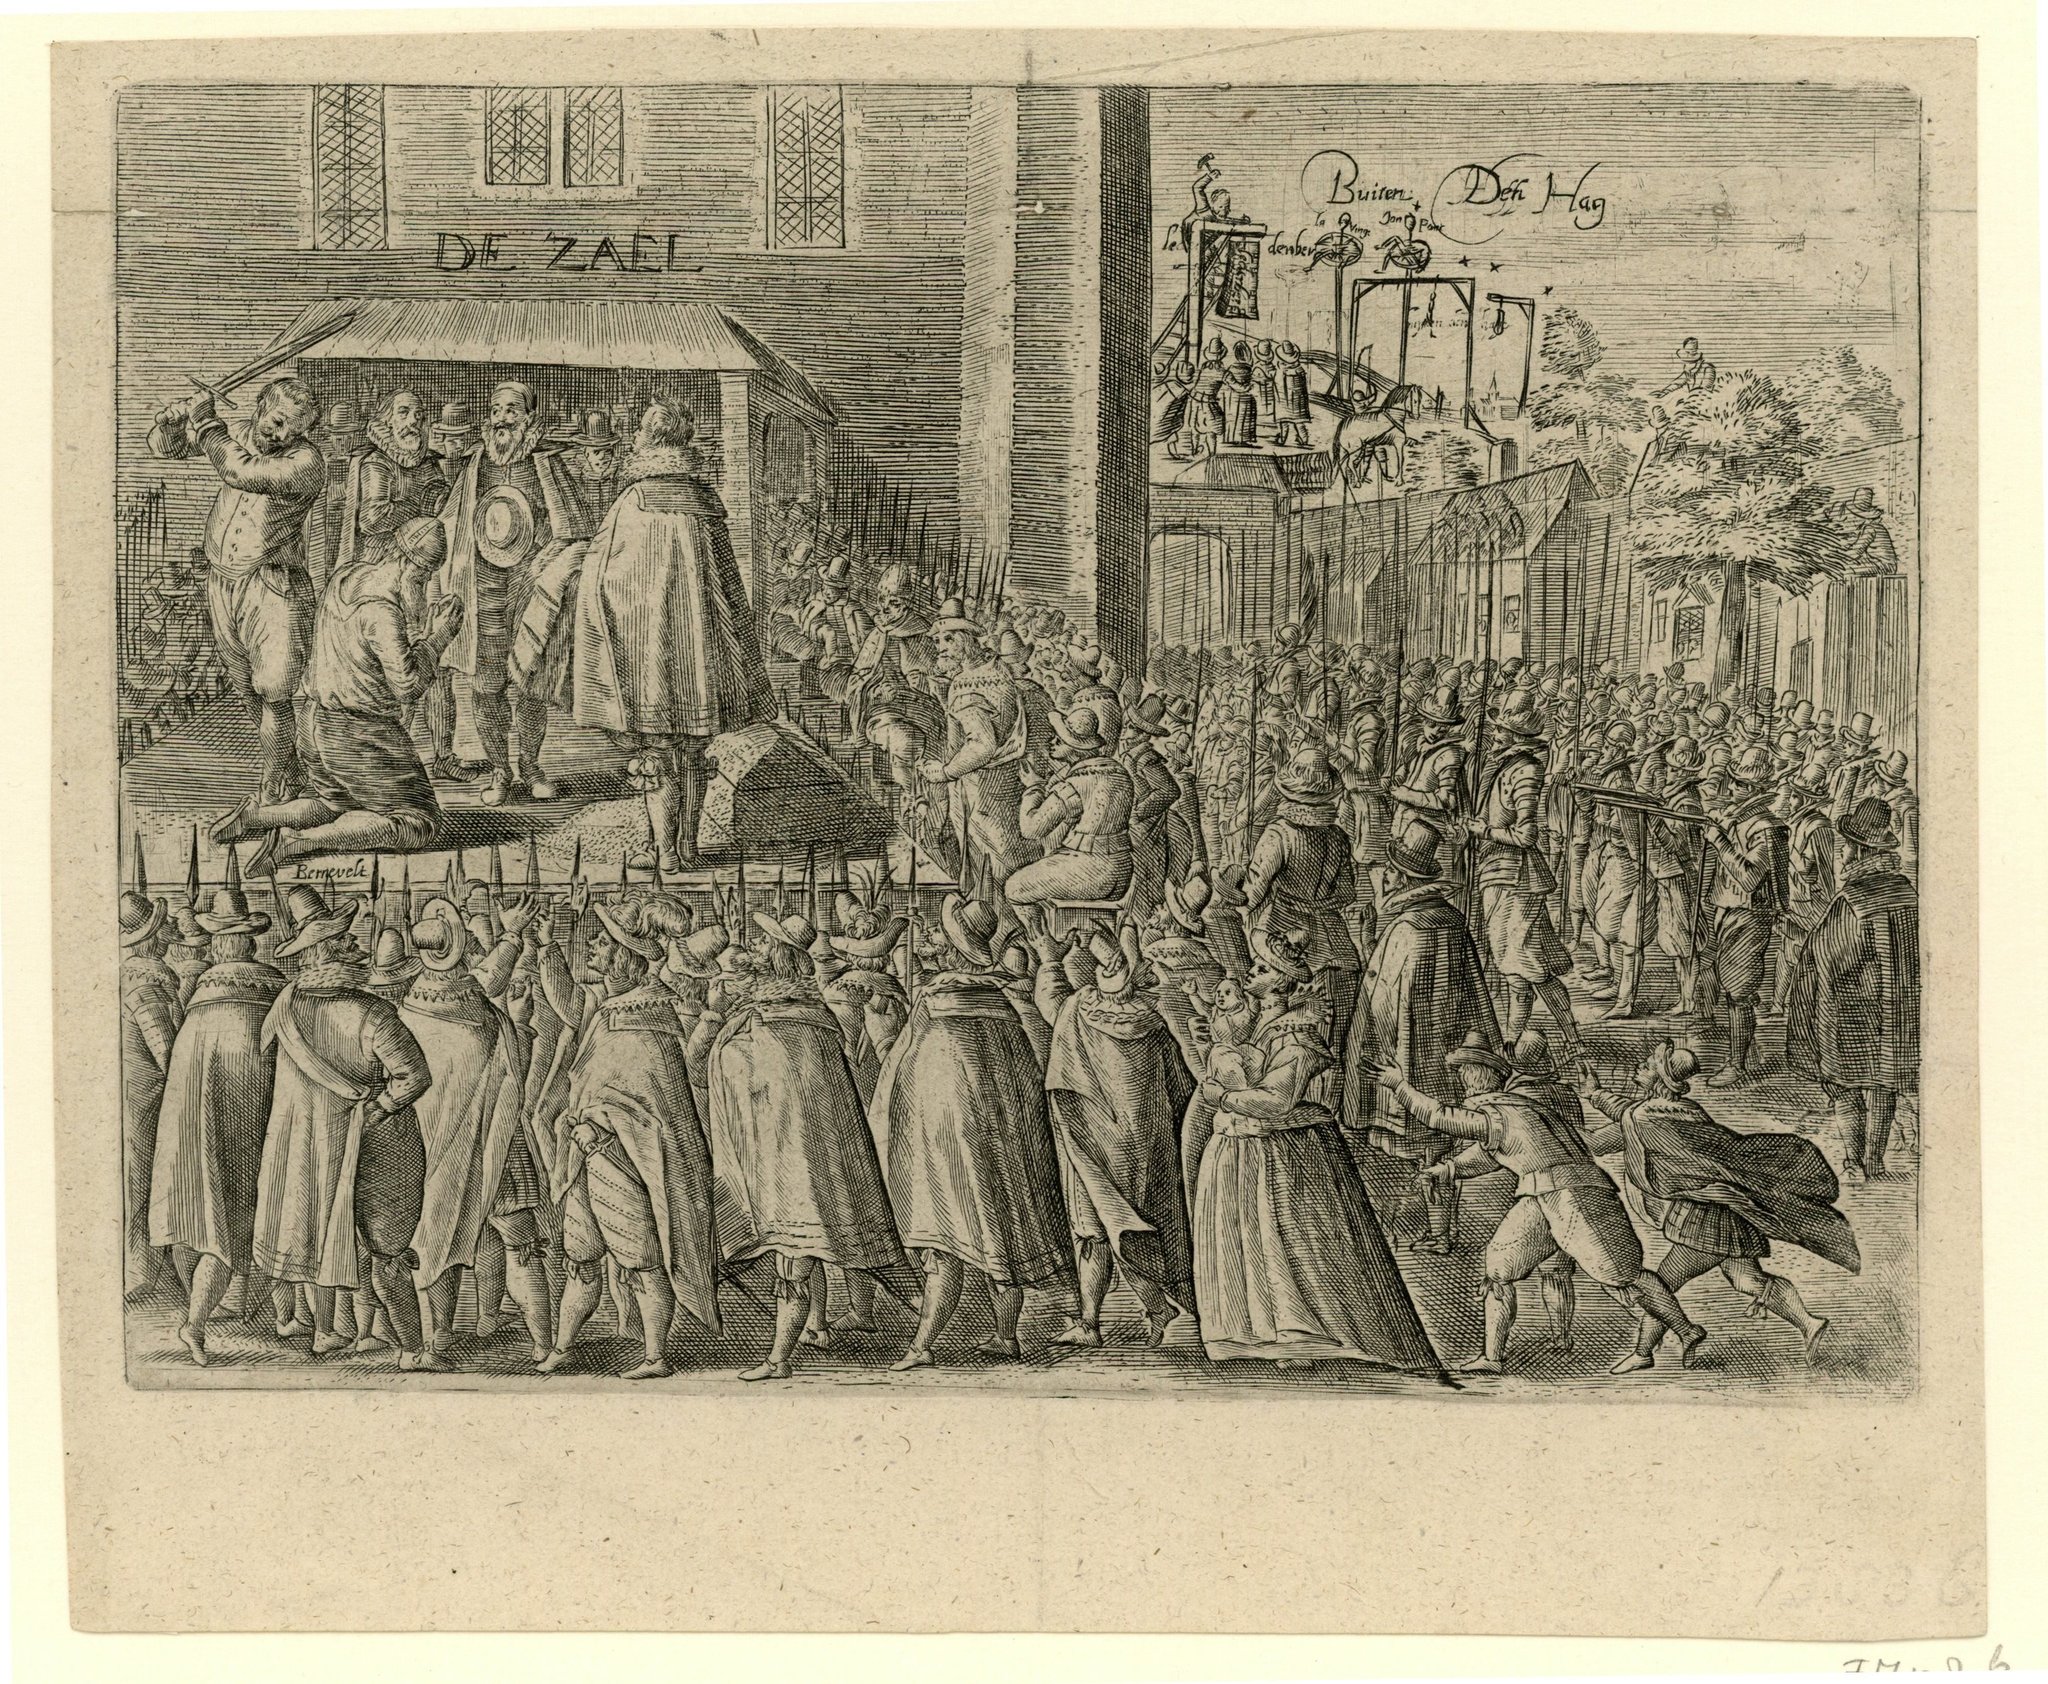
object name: print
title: De onthoofding van Johan van Oldenbarnevelt, 1619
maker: Anonymous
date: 1619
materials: paper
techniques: engraving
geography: northern netherlands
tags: the hague, johan van oldenbarnevelt, utrecht, death penalty, execution, violent death by beheading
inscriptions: collector's mark: Lugt 240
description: Latere staat de originele plaat met verschillende wijzigingen, zo is het gebouw achter het schavot aangeduid als 'De Zael', en zonder het onderschrift met de beschrijving van de gebeurtenissen. Hergebruik van een koperplaat oorspronkelijk vervaardigd voor een voorstelling van de terechtstelling van de samenzweerders van het Buskruitverraad in Londen in 1606.